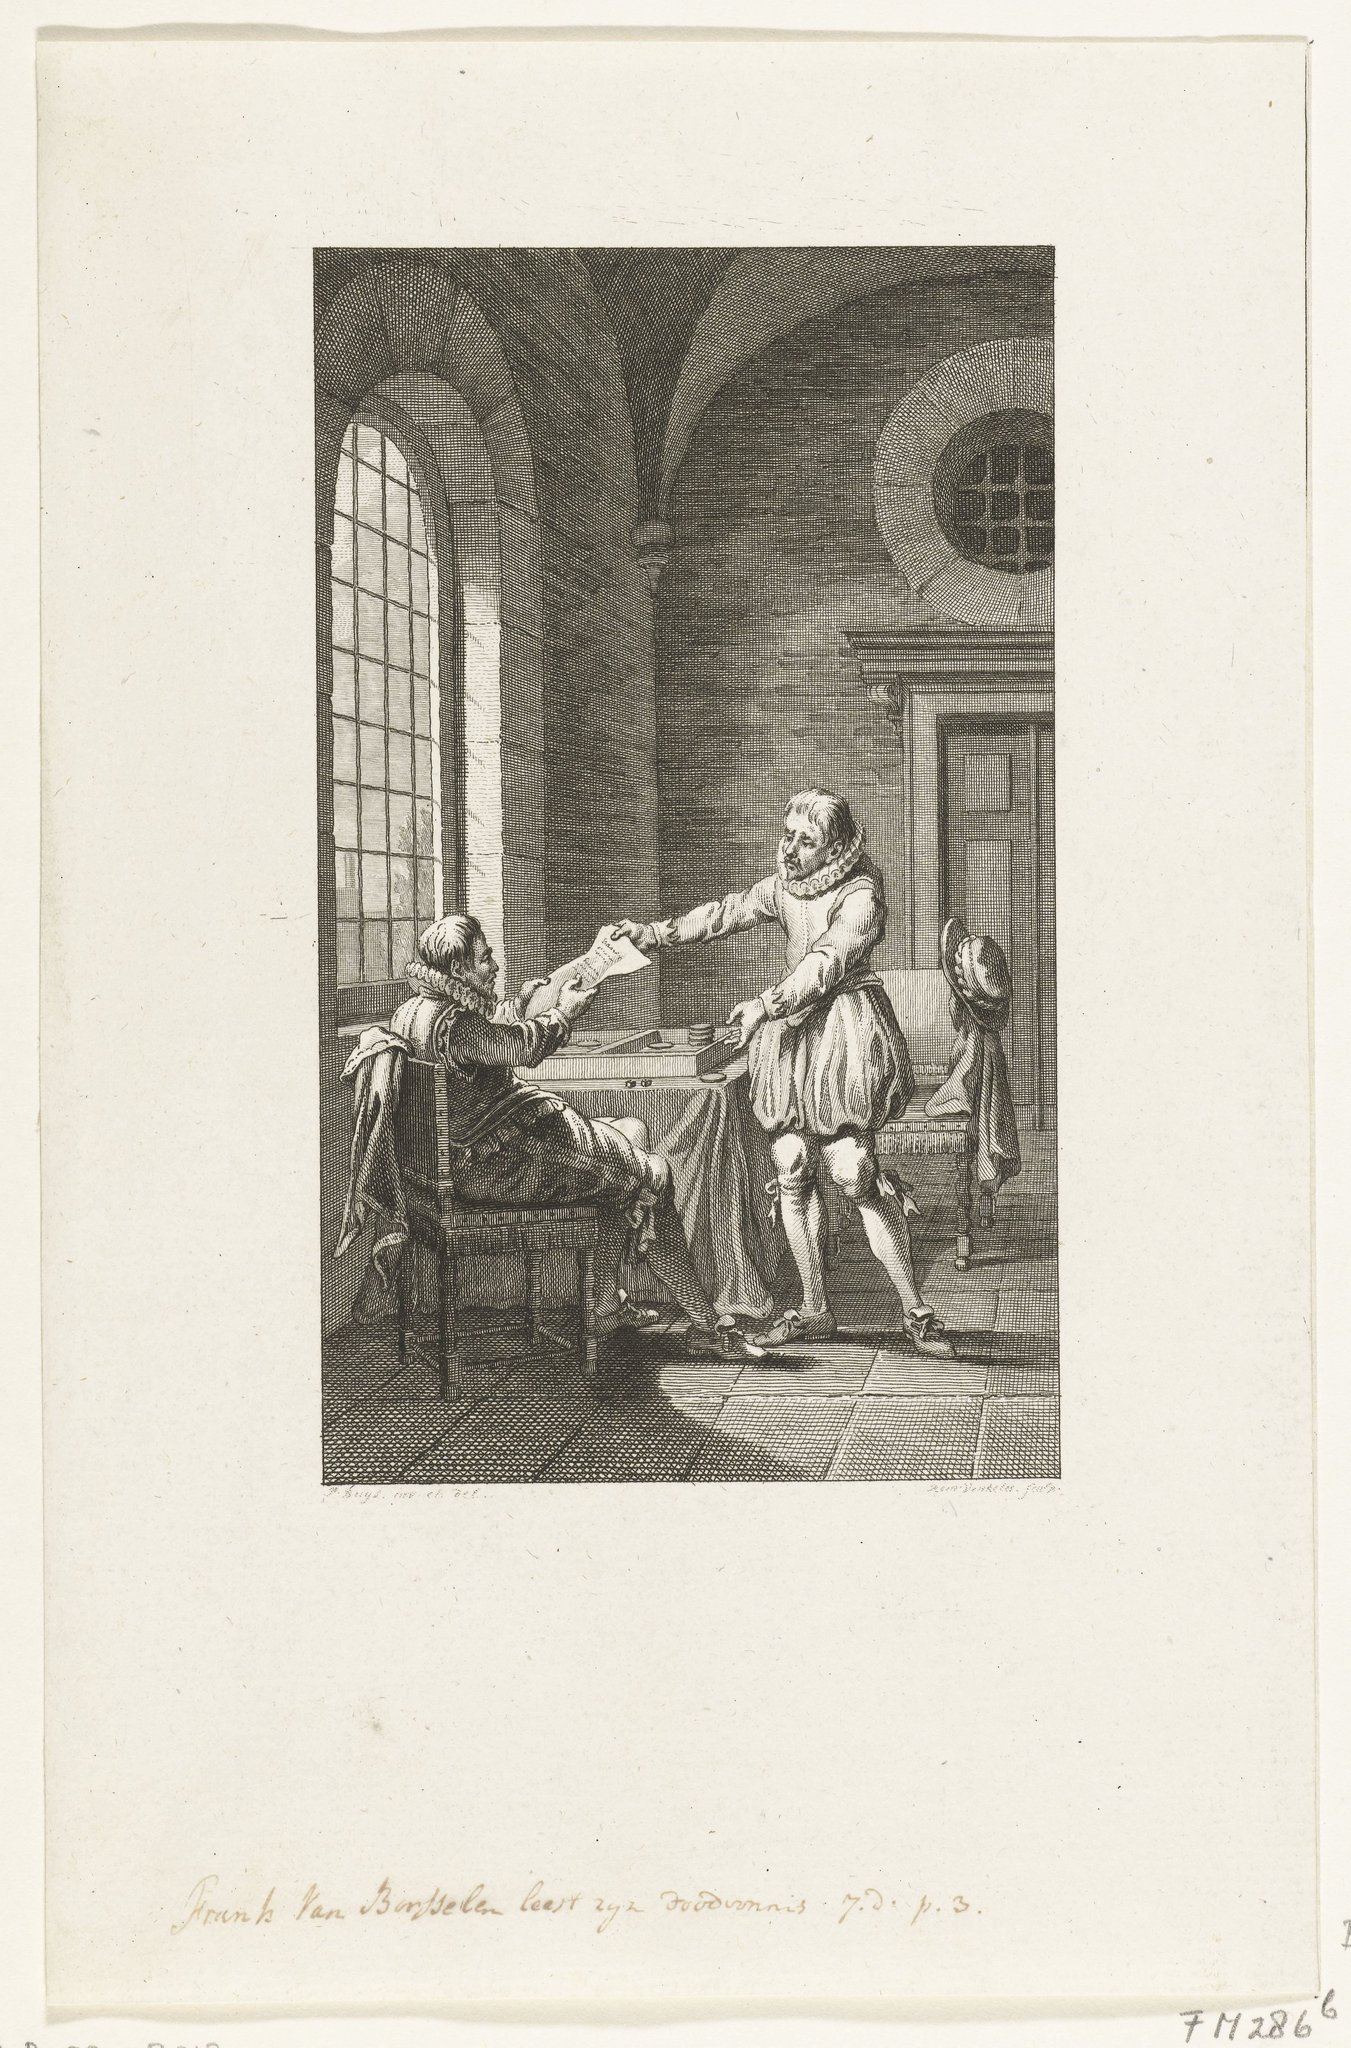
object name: history print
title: Frank van Borselen krijgt zijn doodsvonnis, 1433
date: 1787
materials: paper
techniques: etching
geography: netherlands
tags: bruges, philip iii the good, jacoba of bavaria (countess of hainaut), brielle, ordering the execution of a verdict, burgundian netherlands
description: Frank van Borselen wordt na zijn geheime huwelijk met Jacoba van Beieren door Filips de Goede op het slot Rupelmonde gevangen gezet. Hier krijgt hij tijdens een bordspel met de slotvoogd zijn doodsvonnis overhandigd, 1433.